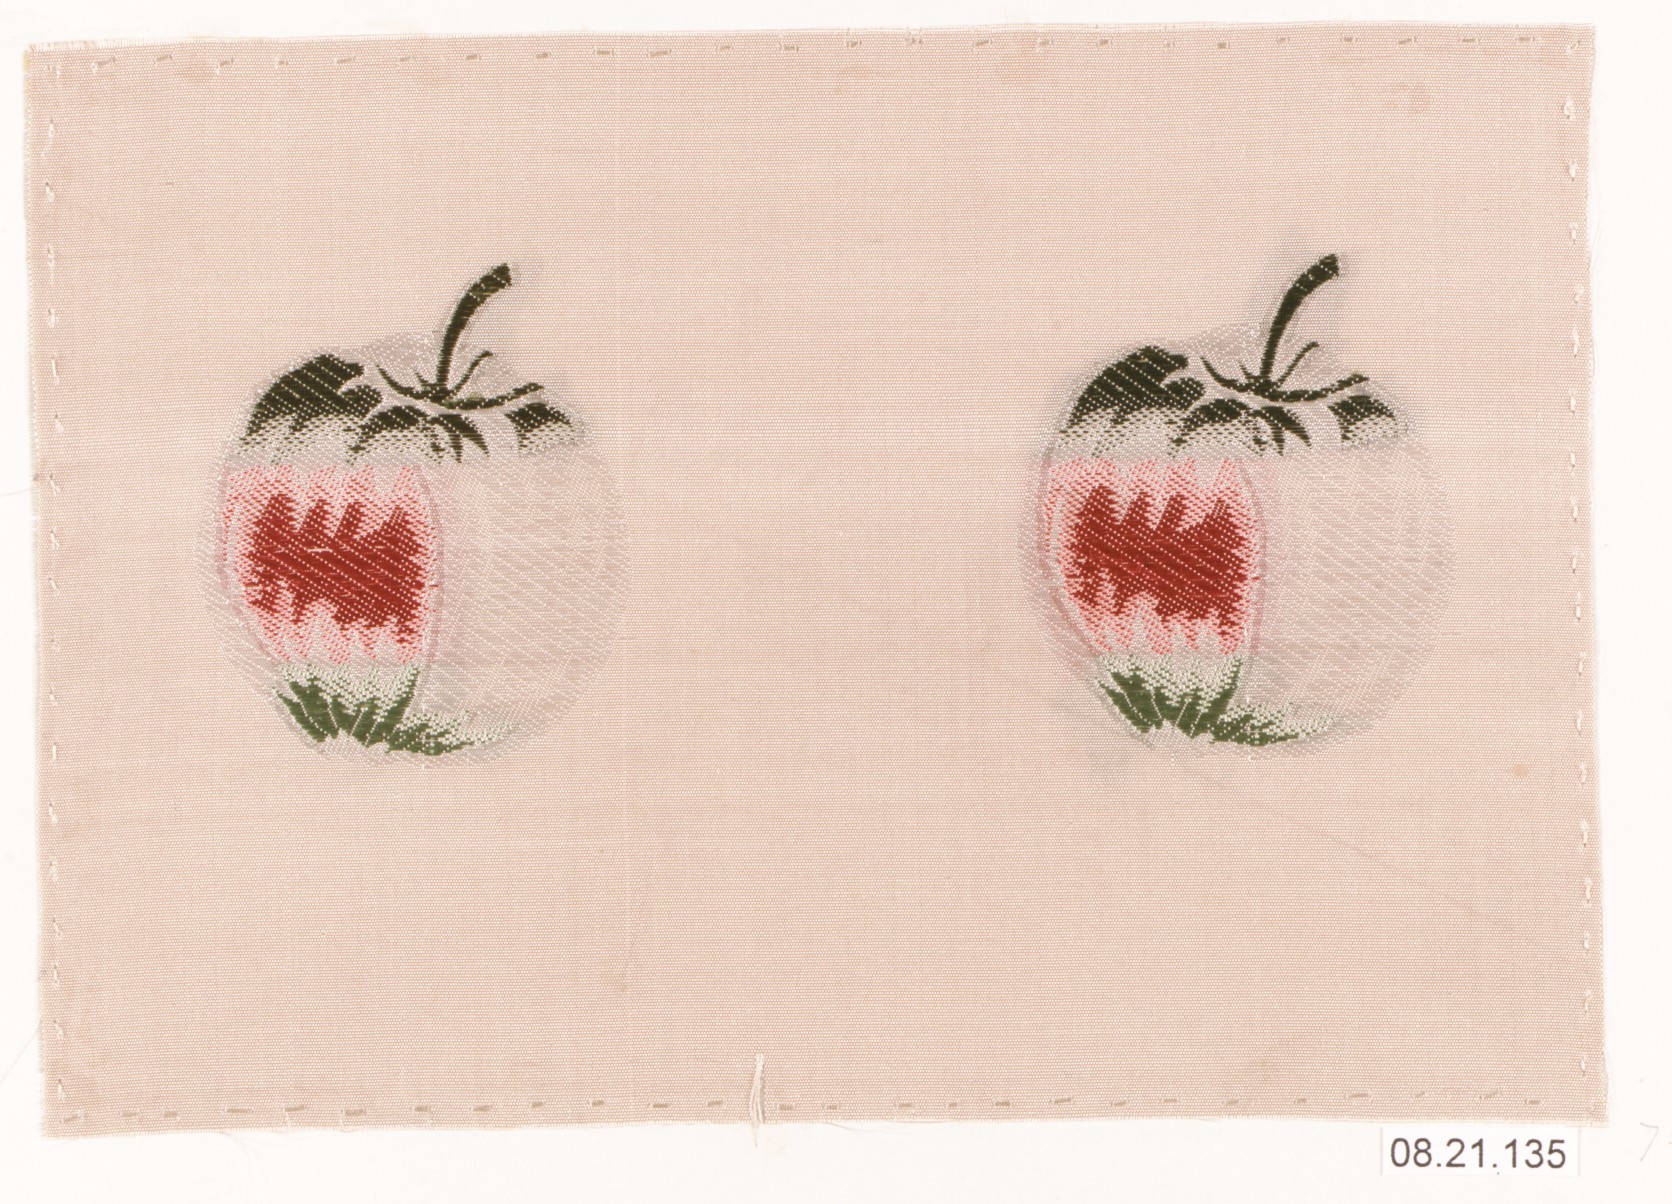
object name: textile sample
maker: Anonymous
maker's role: designer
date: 1900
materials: silk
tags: fruit